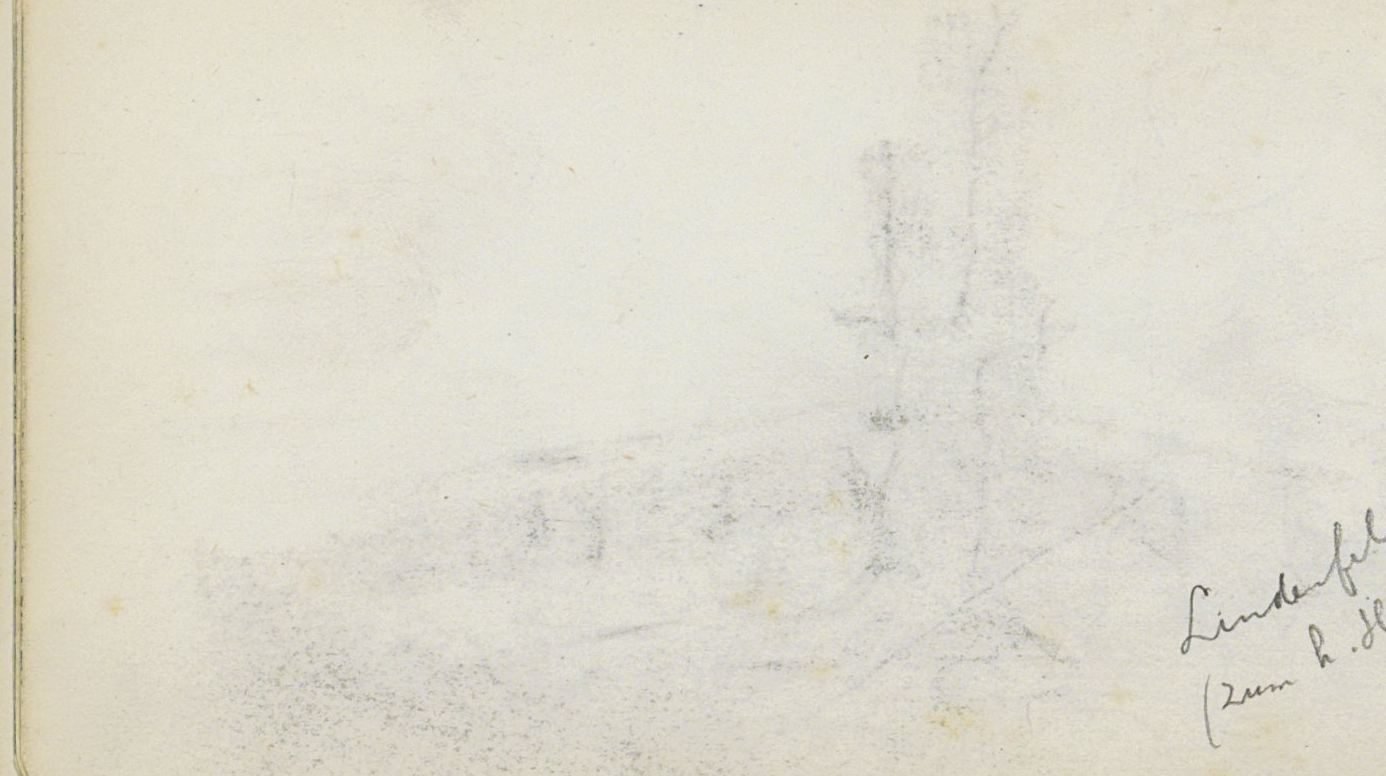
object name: sketchbook leaf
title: Notitie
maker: geo poggenbeek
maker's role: draughtsman, painter, print maker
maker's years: 1853-1903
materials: paper, pencil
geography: lindenfels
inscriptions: annotation: ‘Lindenfels/ (zum L.Haus’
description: Blad 13 verso uit een schetsboek met 69 bladen.